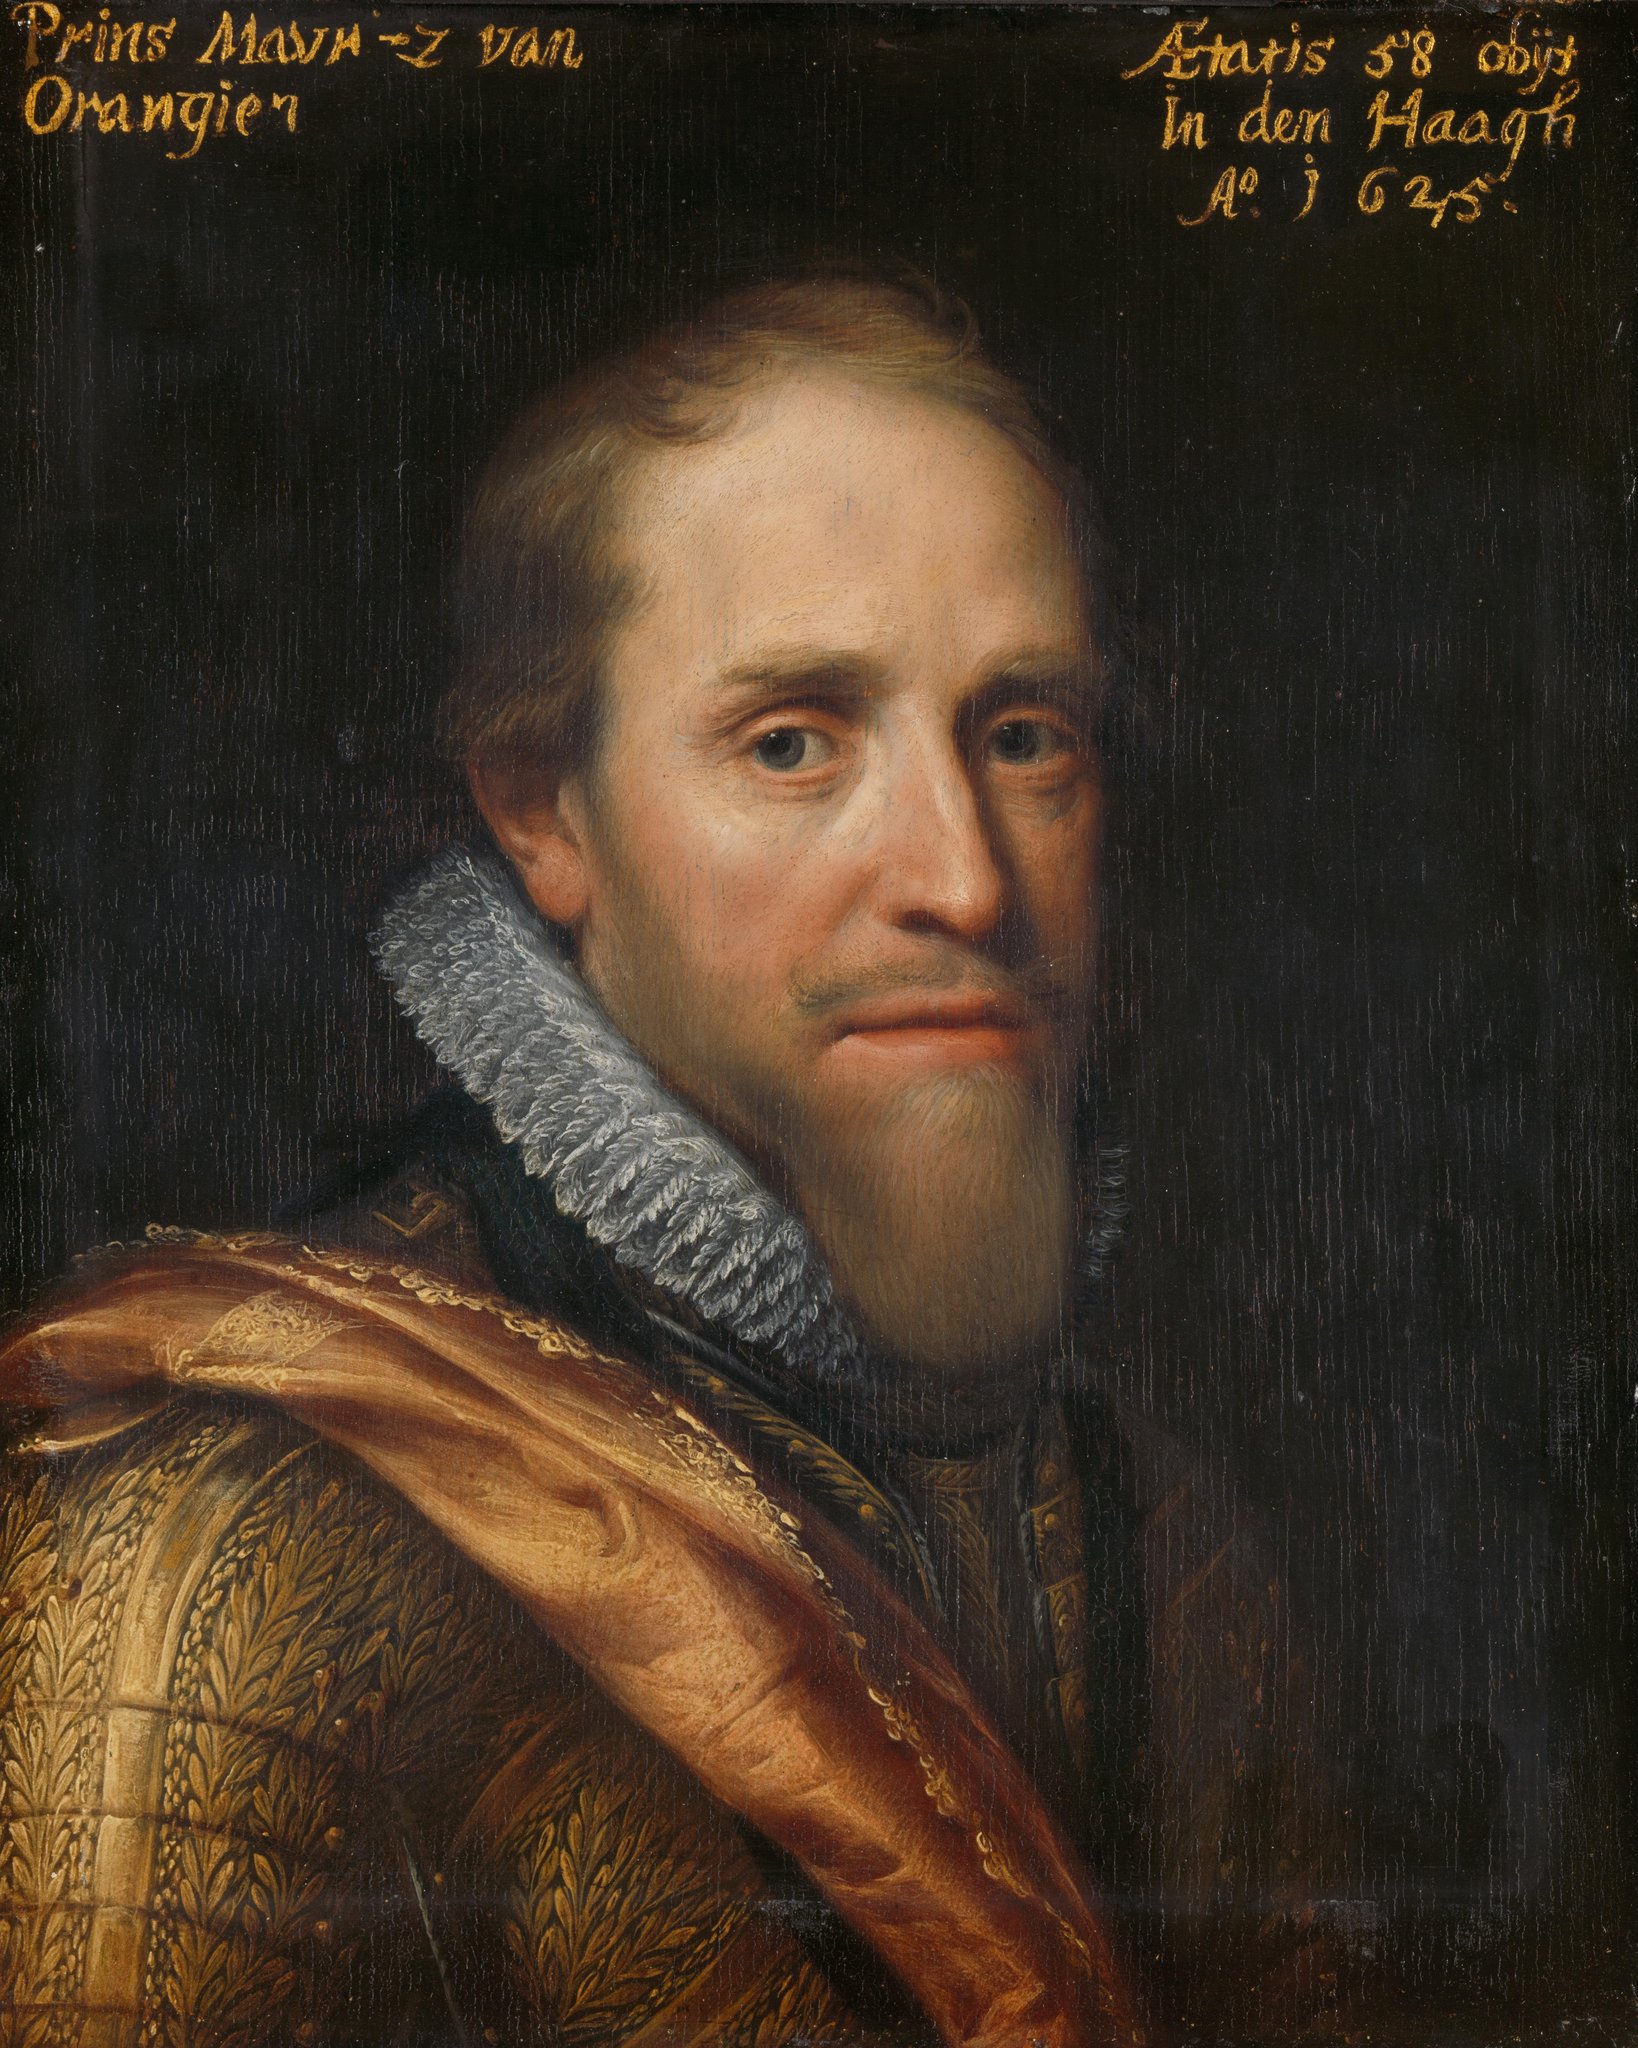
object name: painting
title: Portrait of Maurits (1567-1625), Prince of Orange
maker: michiel jansz van mierevelt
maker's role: draughtsman, painter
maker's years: 1567-1641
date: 1609-1633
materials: oil, panel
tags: maurice (prince of orange), historical persons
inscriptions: inscription, upper left and right: ‘Prins Mauriz von Orangien / Ætatis 58 obijt In den Haagh Aº 1625’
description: These portraits were originally displayed at Honselaarsdijk, the palace built by Stadholder Frederick Henry and his wife Amalia in the 1620s near The Hague. In the style of European courts of the day, one of the palace rooms was lined with portraits of ancestors, relatives and celebrities past and present. Many of these personalities played a role in the Eighty Years War: members of the Nassau family and other commanders of the Dutch Republic's army, officers of the French and English allies and leading Spanish generals. A remarkable aspect is the number of foreigners who fought for the Dutch. The Republic's army enjoyed an international reputation and attracted young noblemen from abroad. For them, the war was a career opportunity.